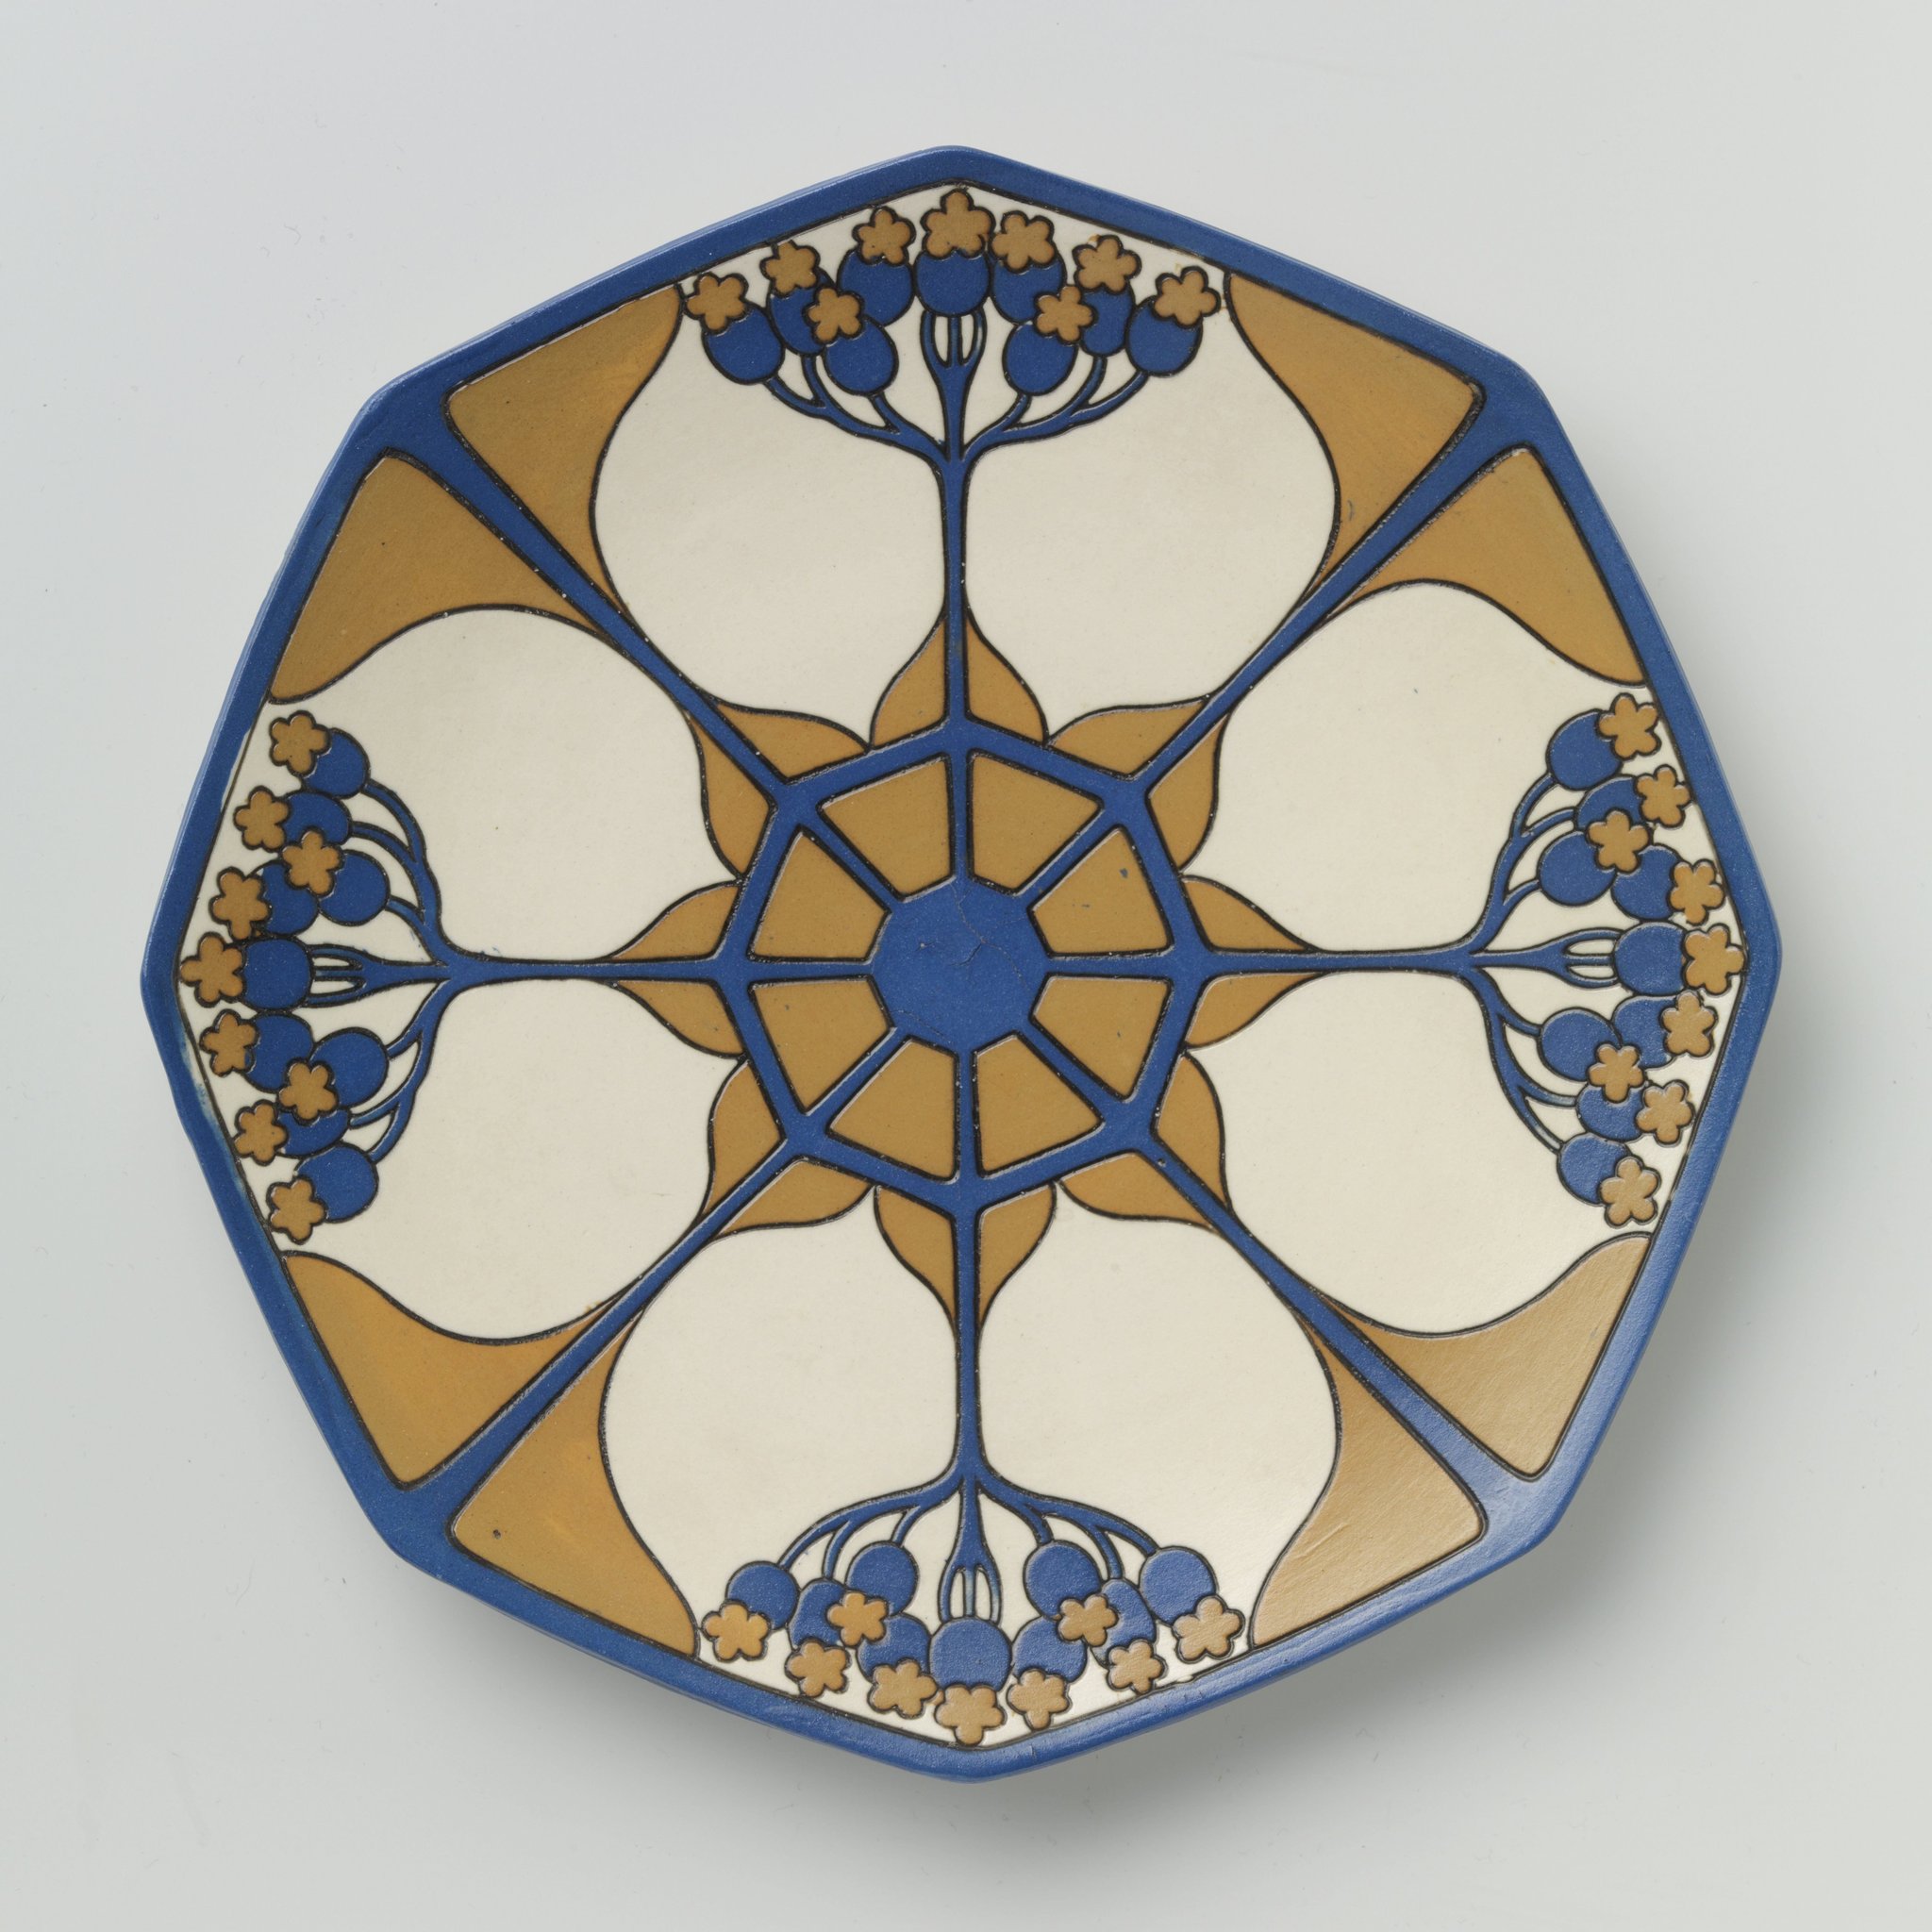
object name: plate dish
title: Bord, behorende bij een theeservies van chromolith steengoed, versierd in blauw en geelbruin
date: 1911-1912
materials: stoneware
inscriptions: mark: ‘ingedrukt toren // METTLACH waaronder VB in naamplaat, Ges.Gesch., Reg. U.S.Pat.OFF // Made in Germany, 3096, 26, 11, II; 69 geschilderd.’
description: Bord, achthoekig, behorende bij een theeservies van chromolith steengoed. Versiering in blauw en geelbruin.